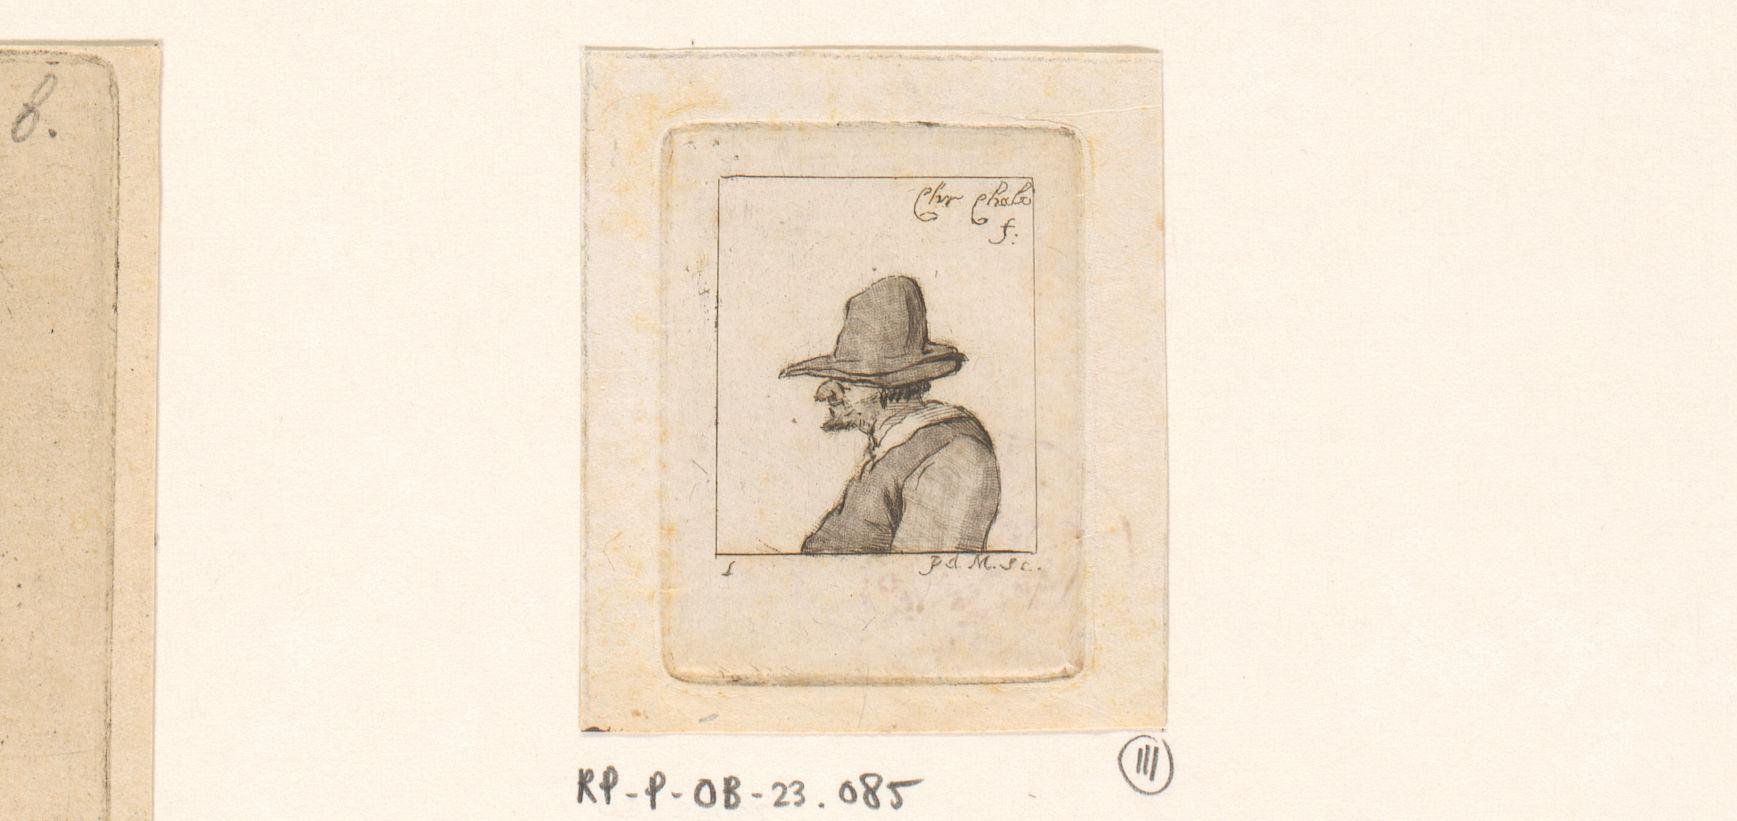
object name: print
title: Buste van een oude boer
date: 1779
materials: paper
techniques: etching, roulette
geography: leiden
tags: head-gear: hat (+ men's clothes)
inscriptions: collector's mark: Lugt 240